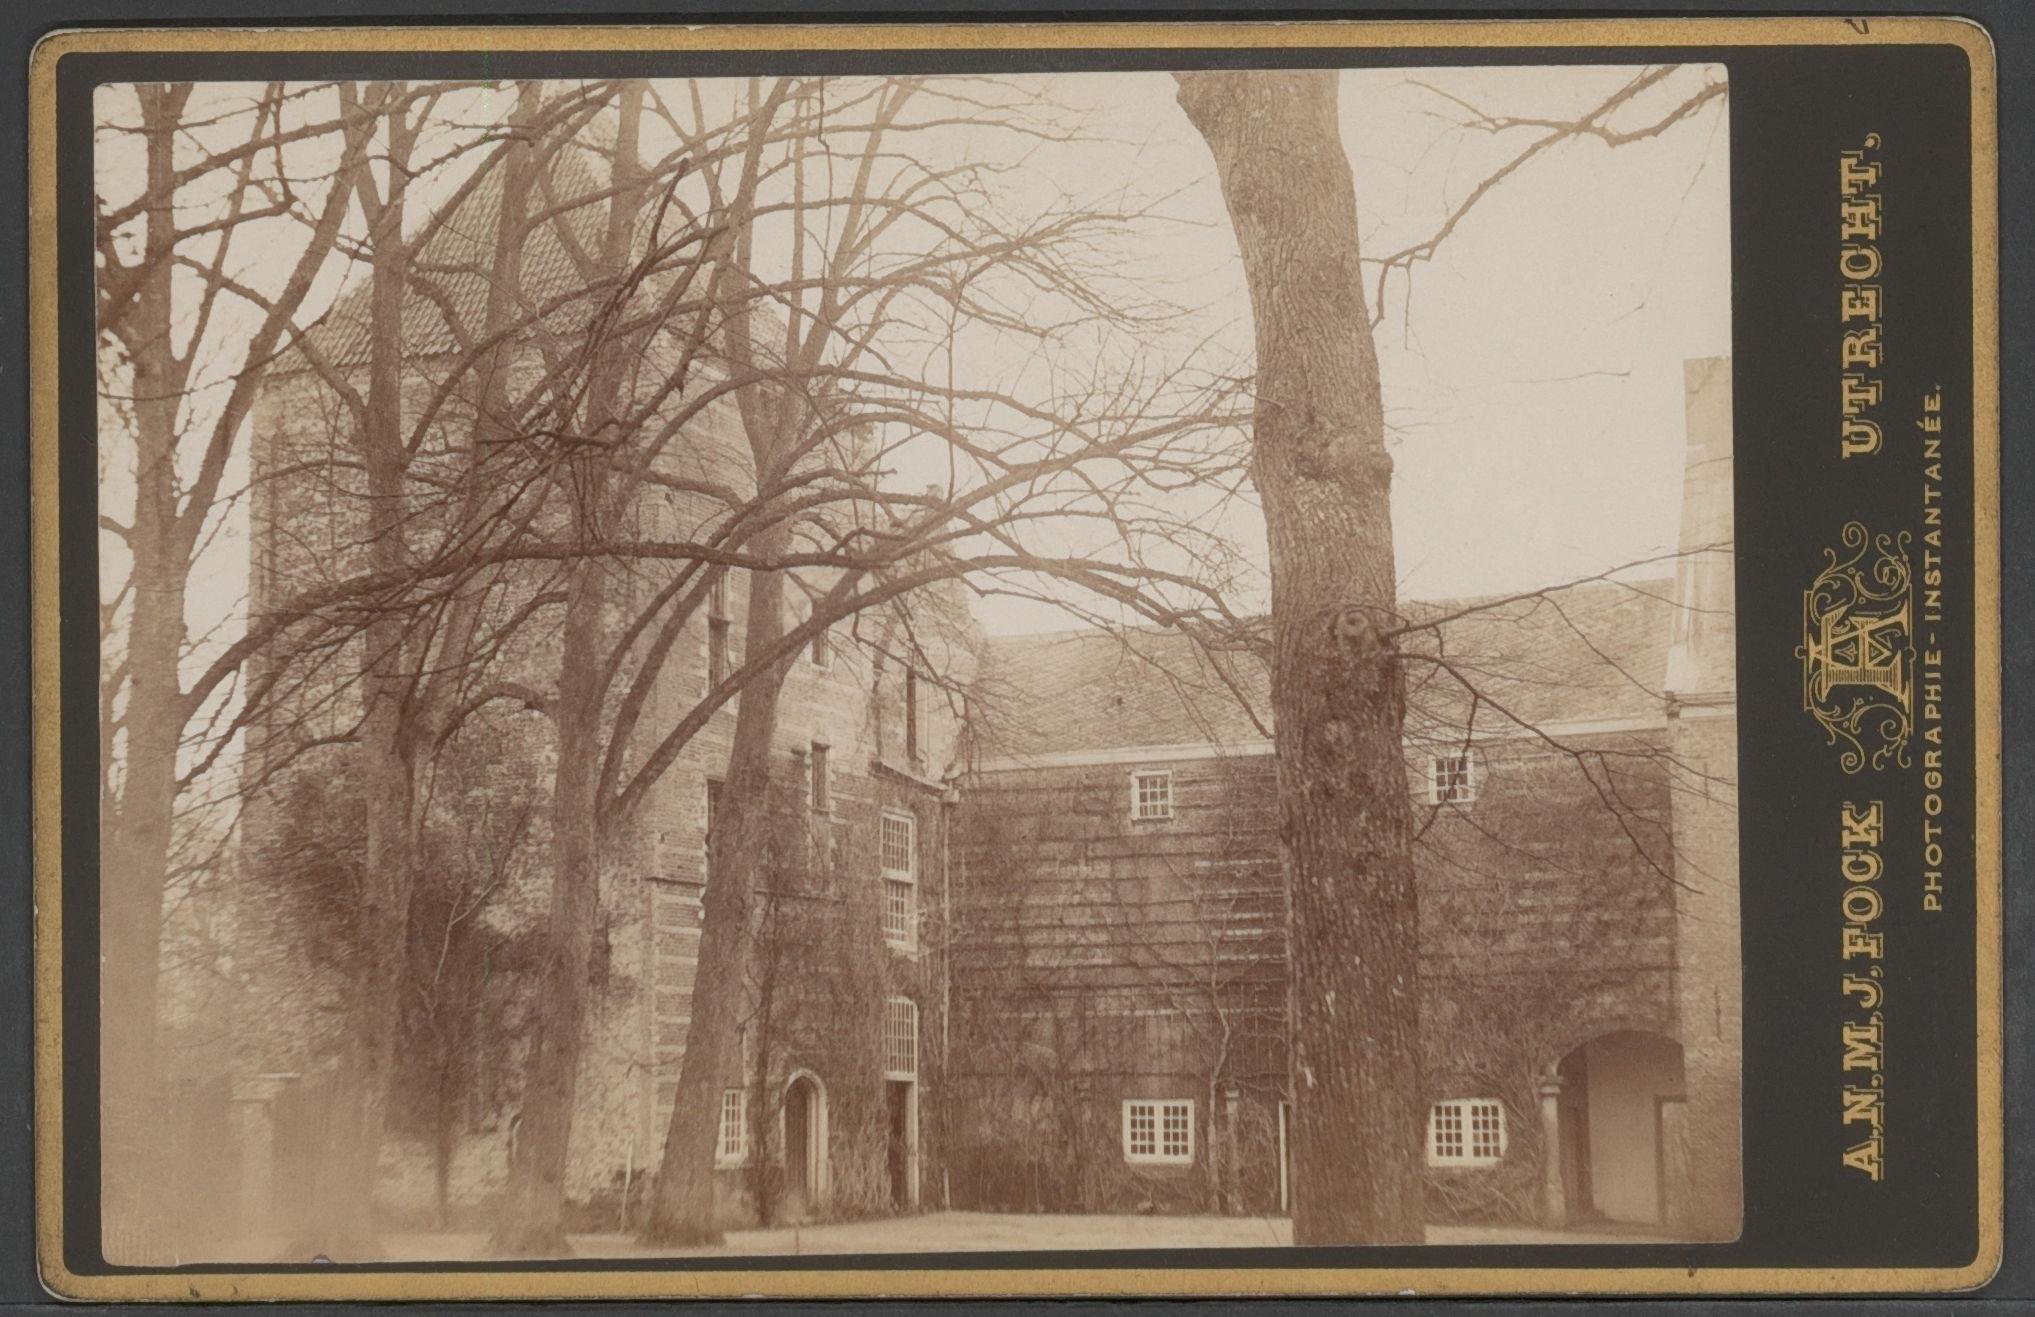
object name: photograph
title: Gezicht op de toren en het binnenplein van Kasteel IJsselstein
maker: arnold nelius marinus johannes fock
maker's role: fotograaf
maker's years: 1846-1901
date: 1867-1887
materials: cardboard, paper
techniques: albumen print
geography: utrecht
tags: trees, castle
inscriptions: stamp, collector's mark: Lugt 1641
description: Onderwerpsrubrieken binnen de Atlas Zeden en Gewoonten: Zeden en Gewoonten in Engeren Zin, De Woning. Kastelen en buitenplaatsen. Holland (vervolg.)